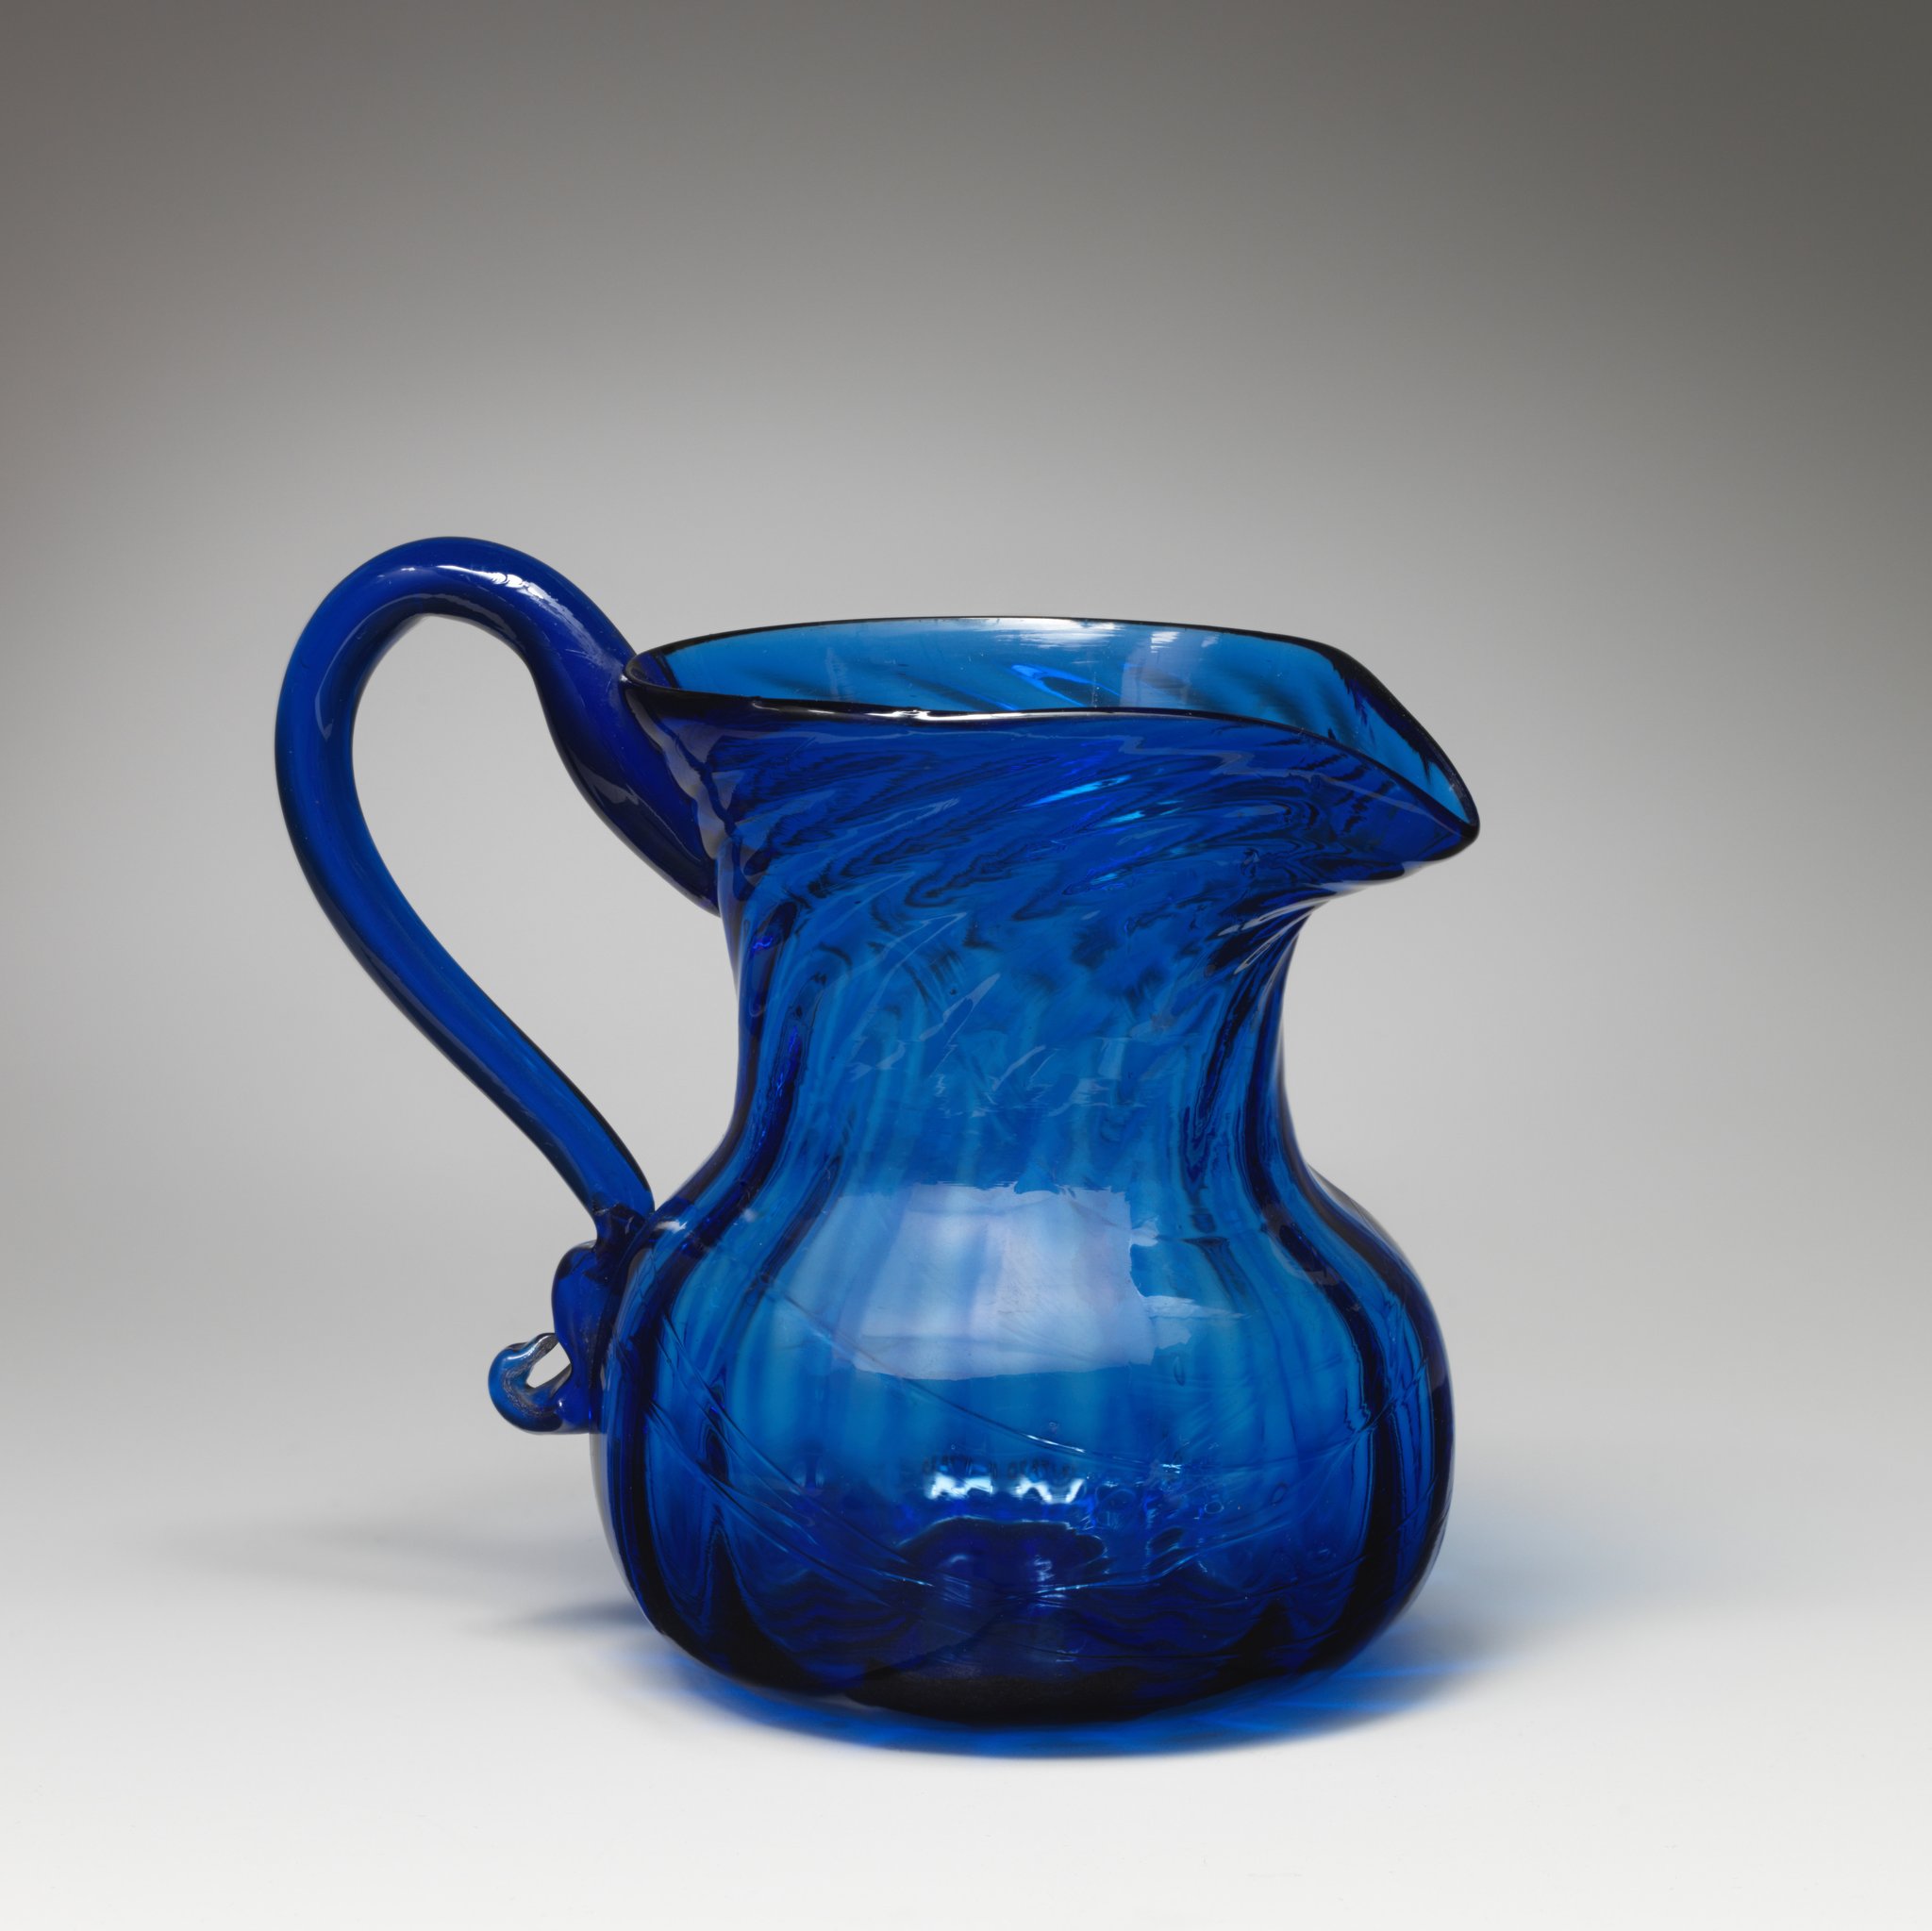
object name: cream jug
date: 1701-1800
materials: glass